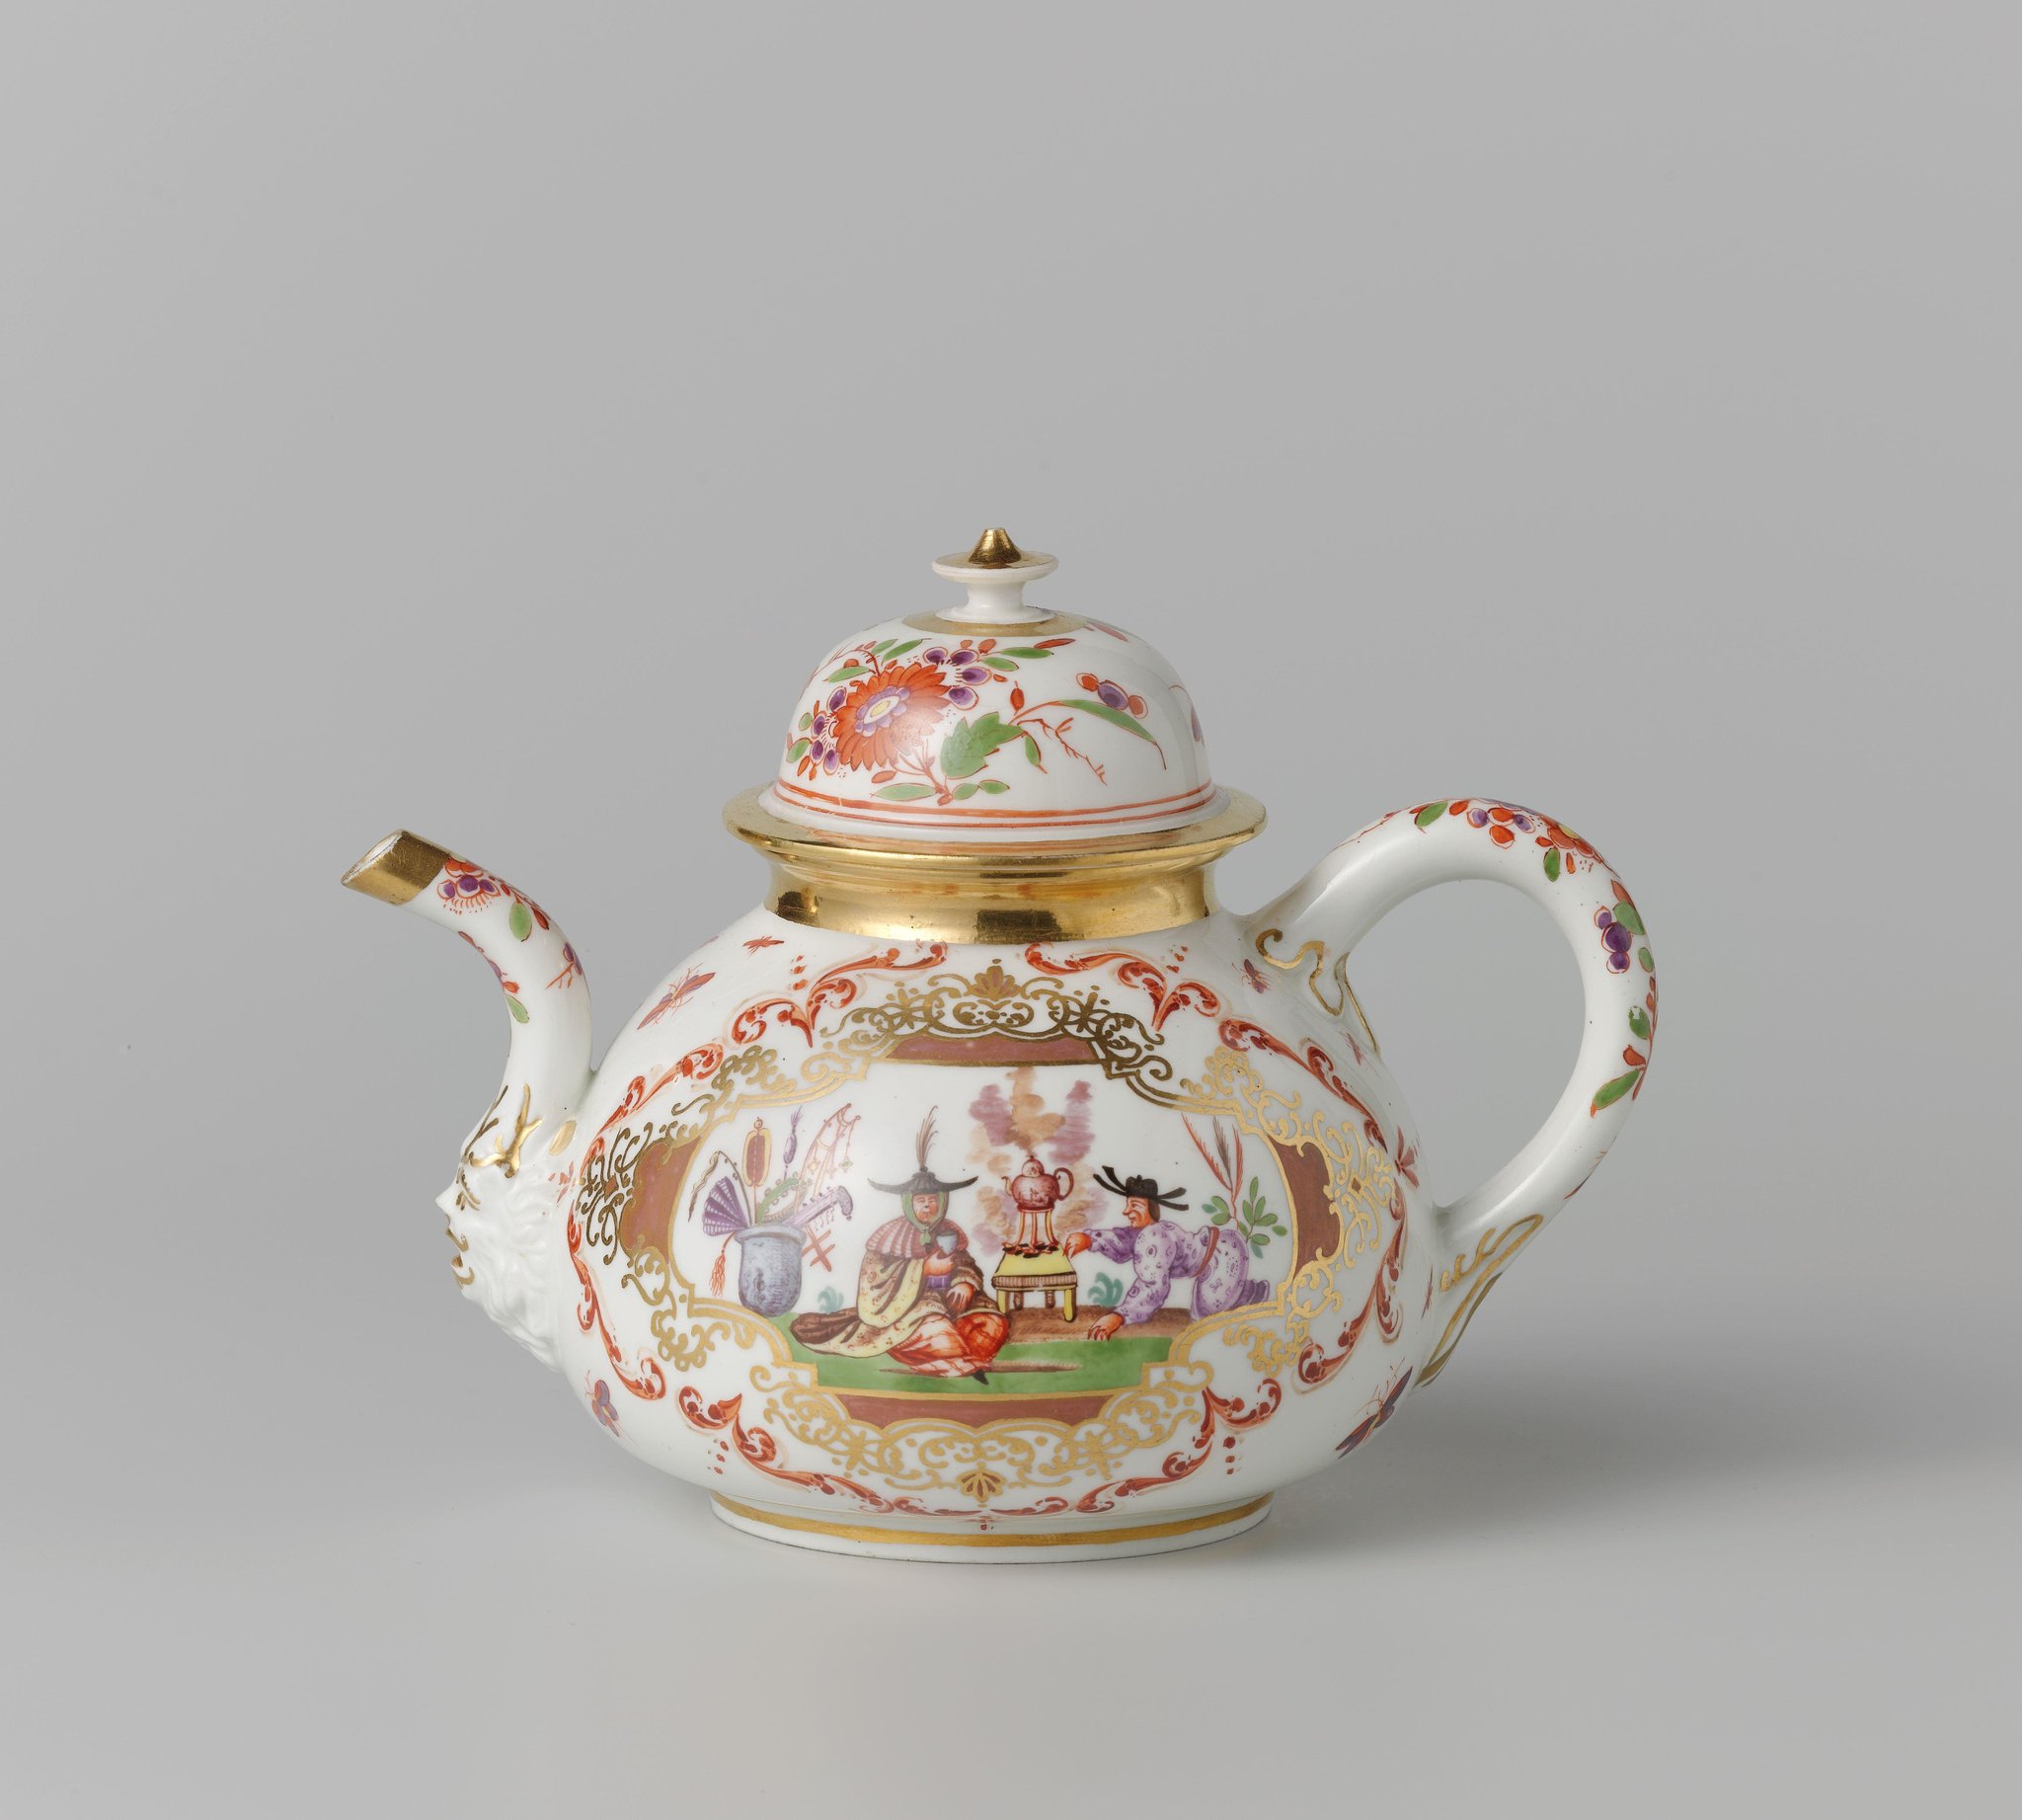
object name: eating drinking utensil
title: Theepot, veelkleurig beschilderd met chinoiserieën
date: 1725-1730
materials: porcelain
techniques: painted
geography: meissen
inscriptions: factory mark, inscription: ‘38.’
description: Theepot van beschilderd porselein, met een deels verguld masker onder de tuit. Het oor loopt aan beide zijden uit in deels vergulde bladeren. Aan beide zijden van het lichaam zijn Höroldt-chinoiserieën geschilderd binnen cartouches met ingezwenkte hoeken. Tussen de cartouches zijn insekten en vlinders geschilderd. Het deksel, het oor en de tuit zijn versierd met Indianische Blumen. De theepot is gemerkt.